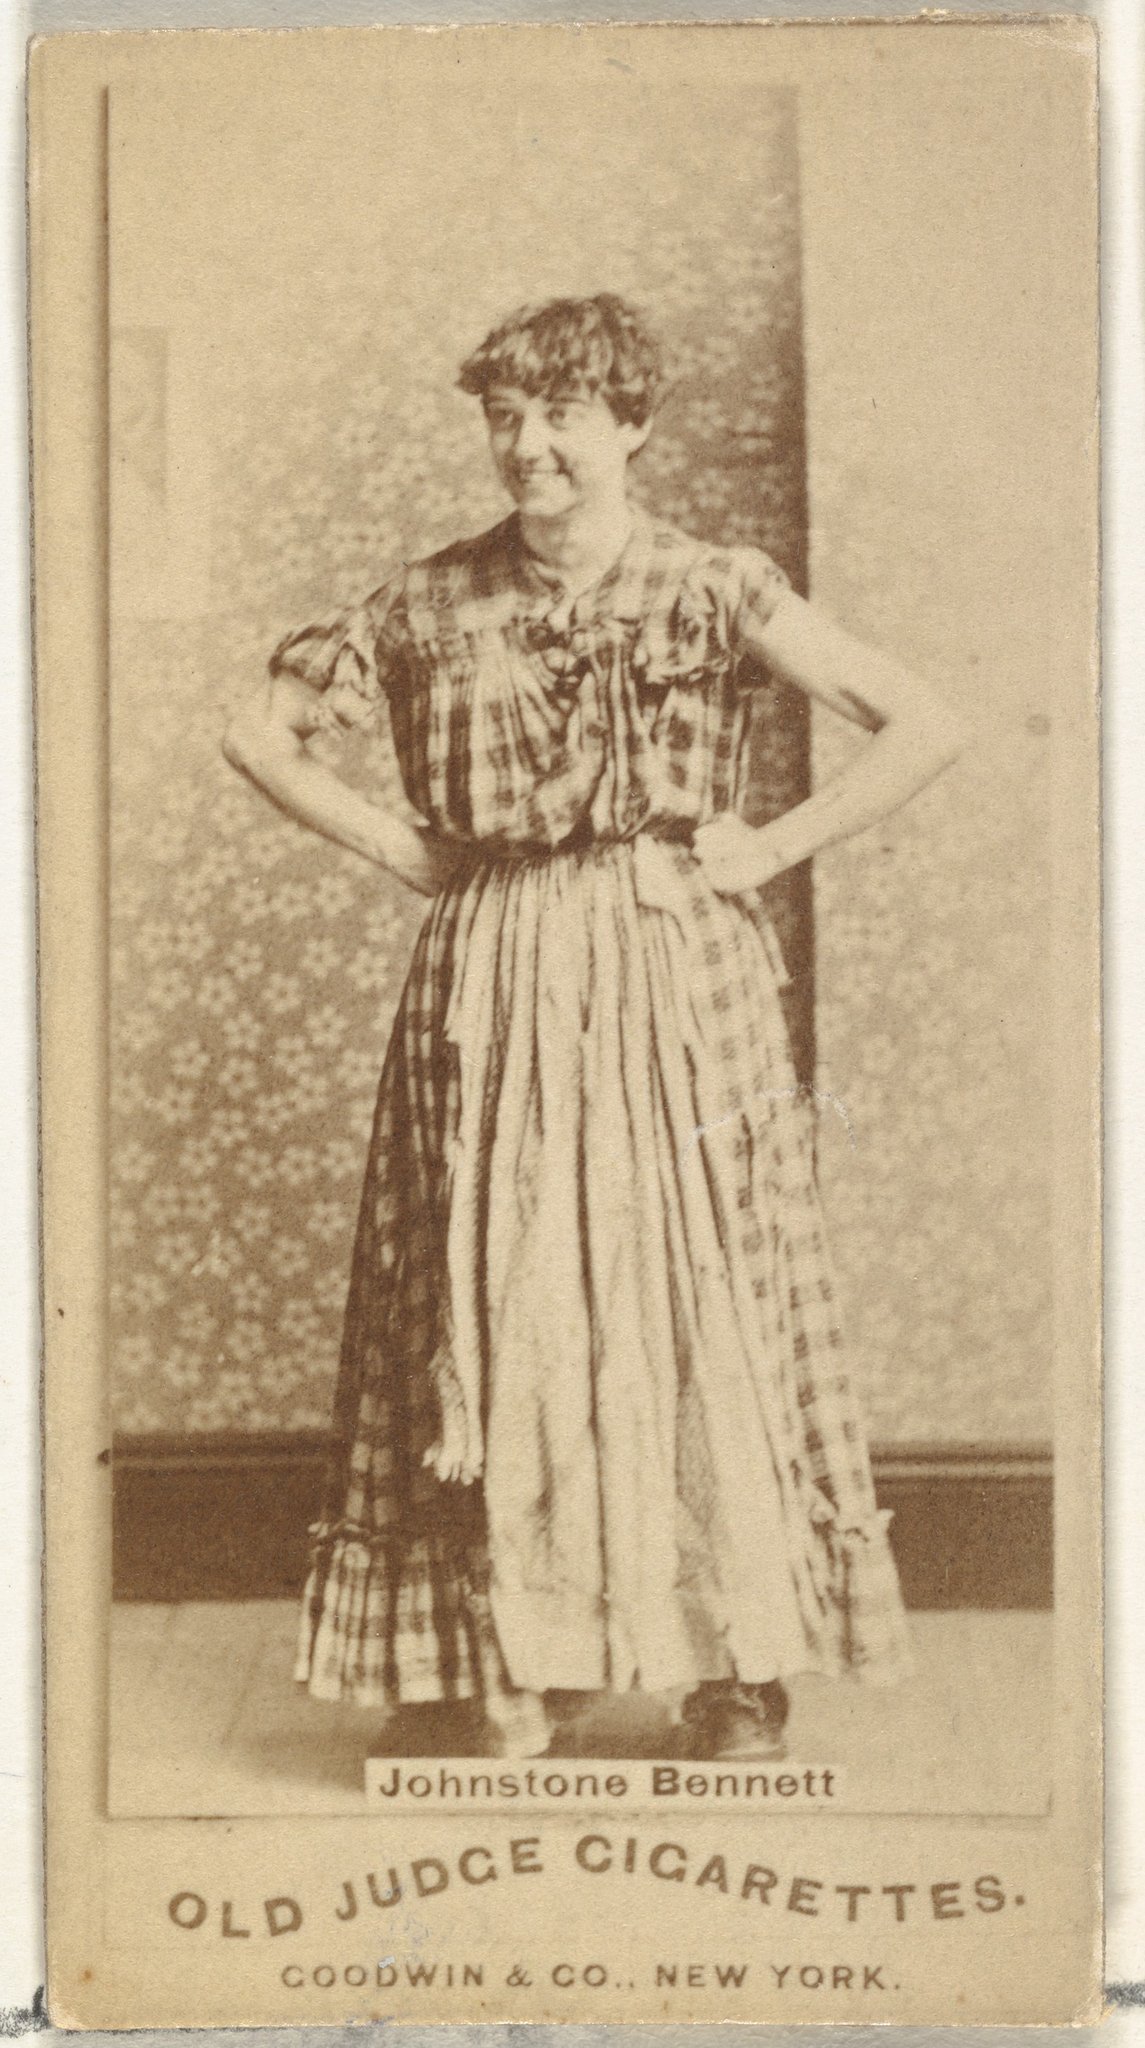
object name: photograph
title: Johnstone Bennett, from the Actors and Actresses series (N171) for Old Judge Cigarettes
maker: goodwin & company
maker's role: publisher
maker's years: 1850-1950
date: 1886-1890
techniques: albumen silver print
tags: portraits,women,actresses